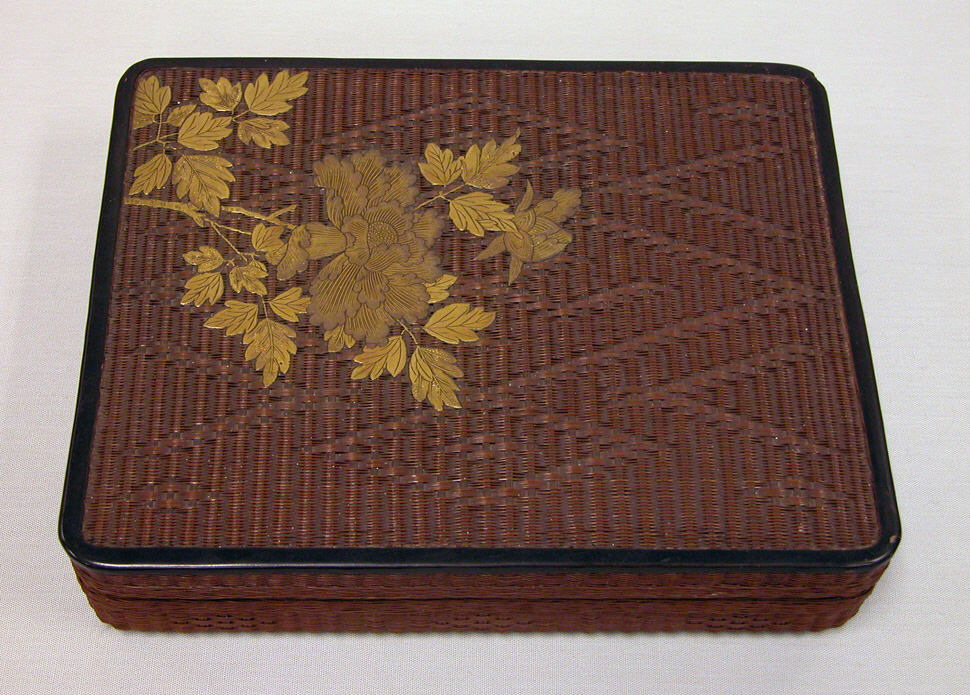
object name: box with cover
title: Basketwork Box with Peonies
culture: japanese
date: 1834-1866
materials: bamboo, gold, lacquer, rattan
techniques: hiramakie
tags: peonies